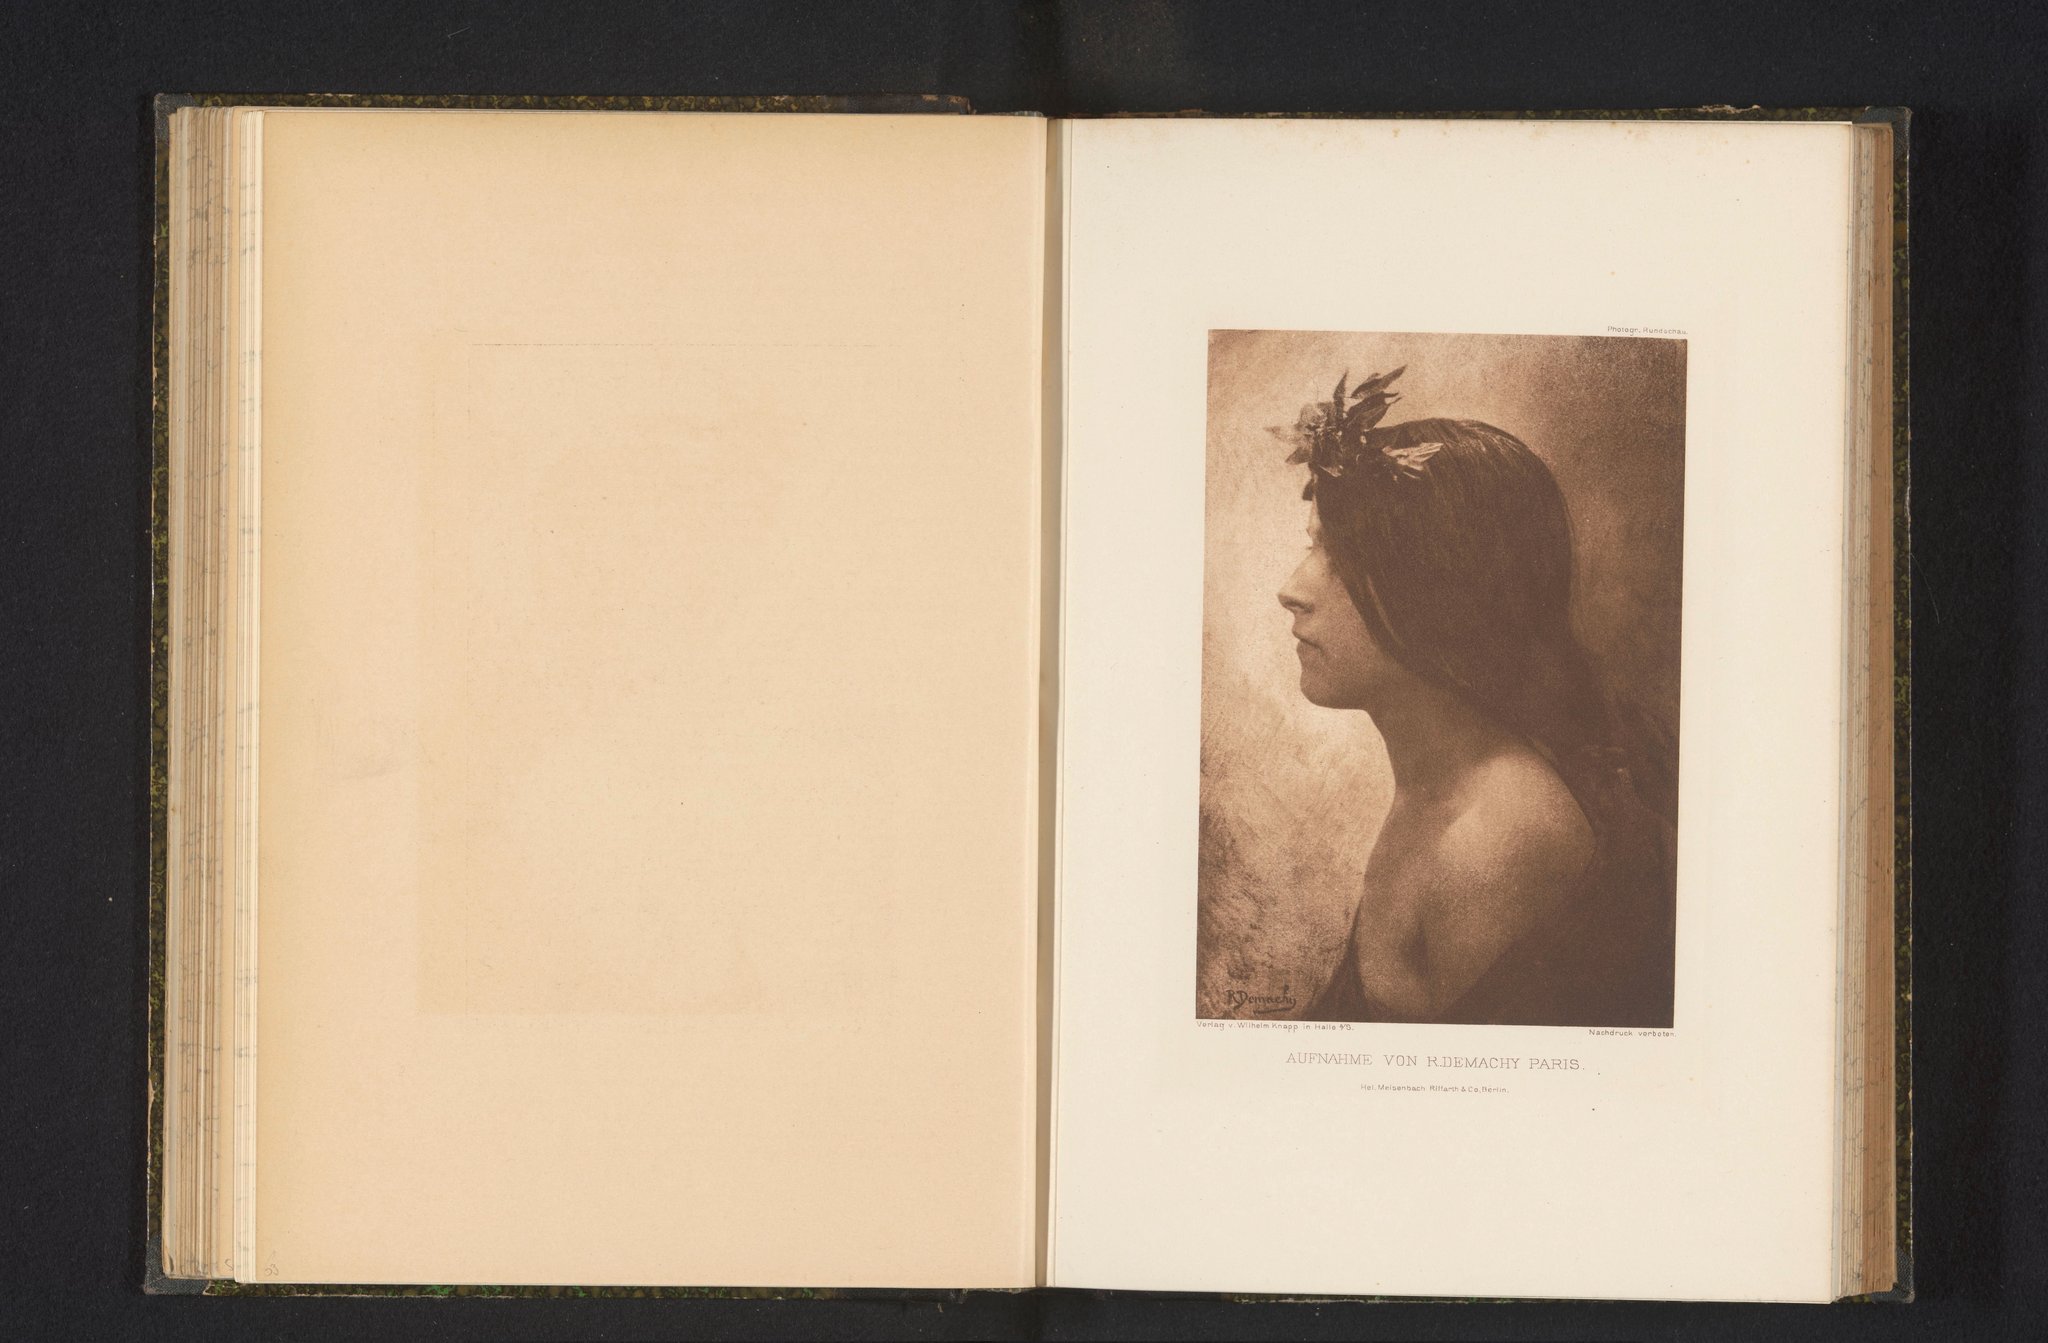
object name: page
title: Portret van een onbekende vrouw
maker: robert demachy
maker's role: fotograaf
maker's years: 1859-1936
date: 1893-1898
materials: paper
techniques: photoaquatint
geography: berlin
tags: adult woman